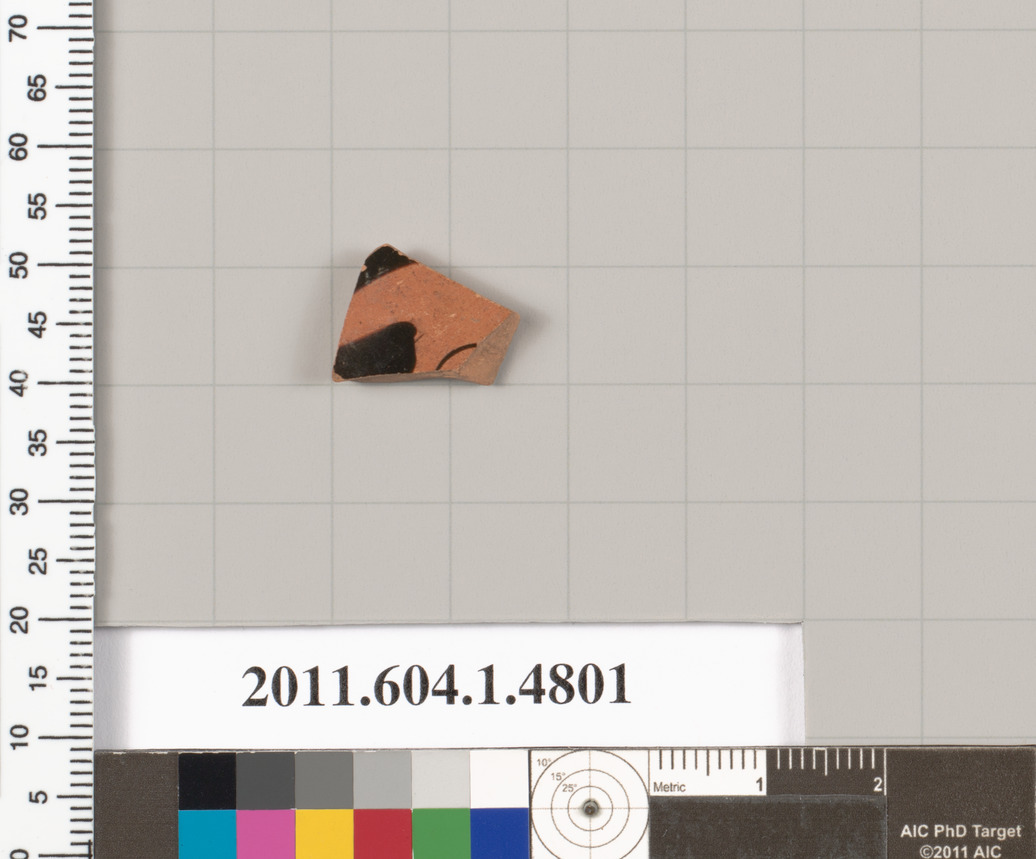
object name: kylix fragment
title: Terracotta fragment of a kylix (drinking cup)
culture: greek, attic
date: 475-451 BCE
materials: terracotta